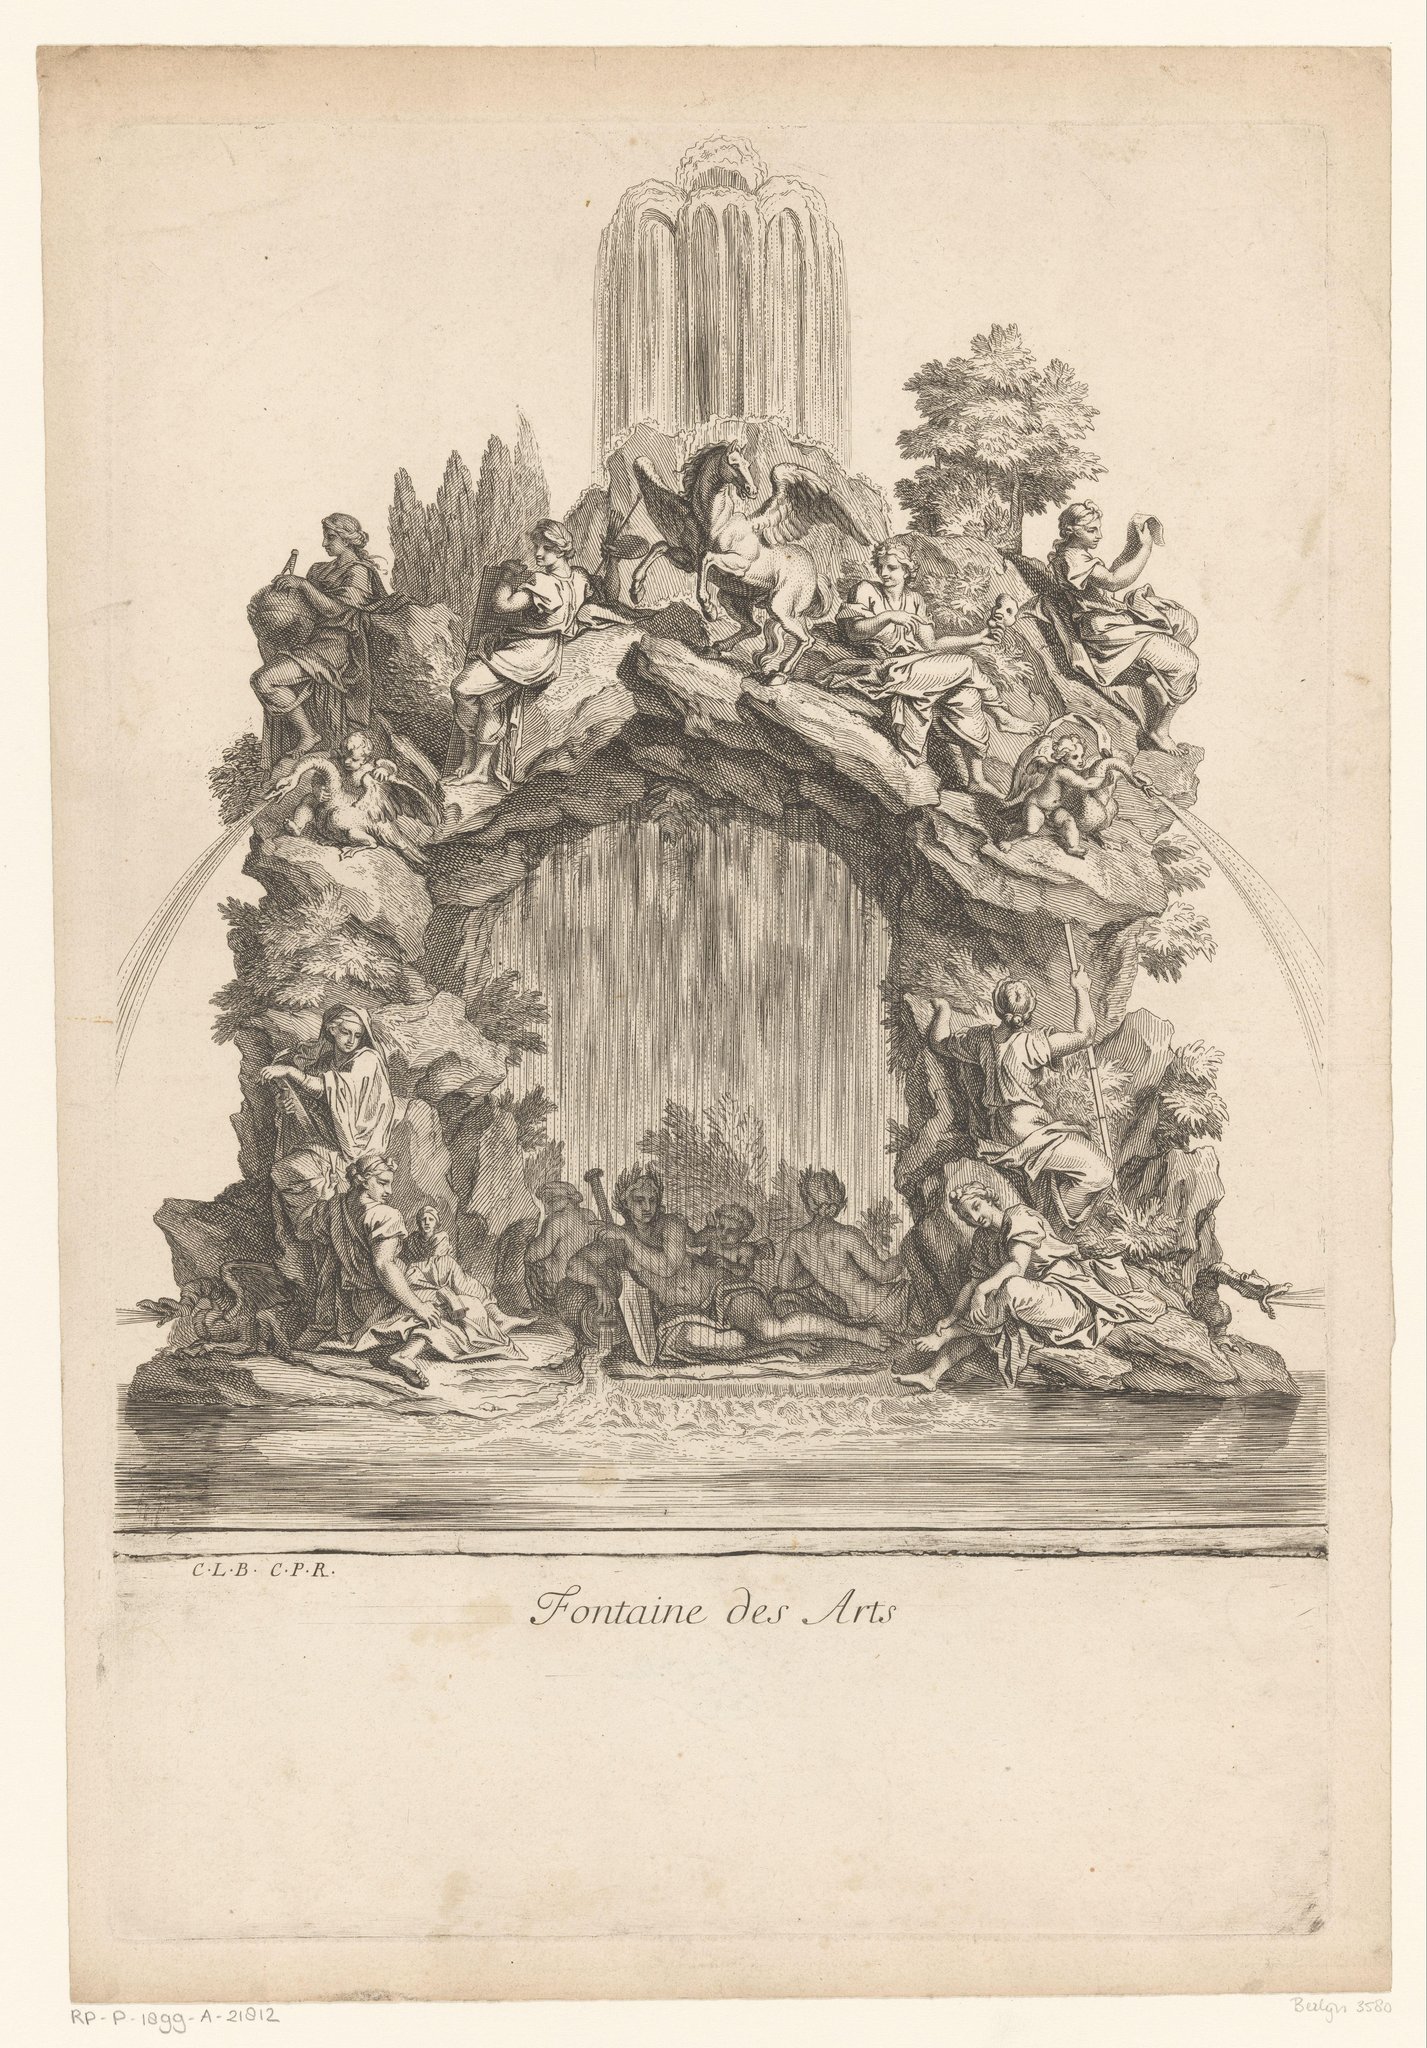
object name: ornament print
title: Fontaine des Arts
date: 1672-1686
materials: paper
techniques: etching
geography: paris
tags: symbolic representations, allegories and emblems ~ art; 'arte' (ripa), ornamental fountain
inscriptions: collector's mark: Lugt 2228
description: Een fontein in de vorm van een grot met Pegasus, putti en vrouwen. Op en rondom de grot zitten putti en acht vrouwen als personificaties van de kunsten. In de grot ligt een riviergodin.